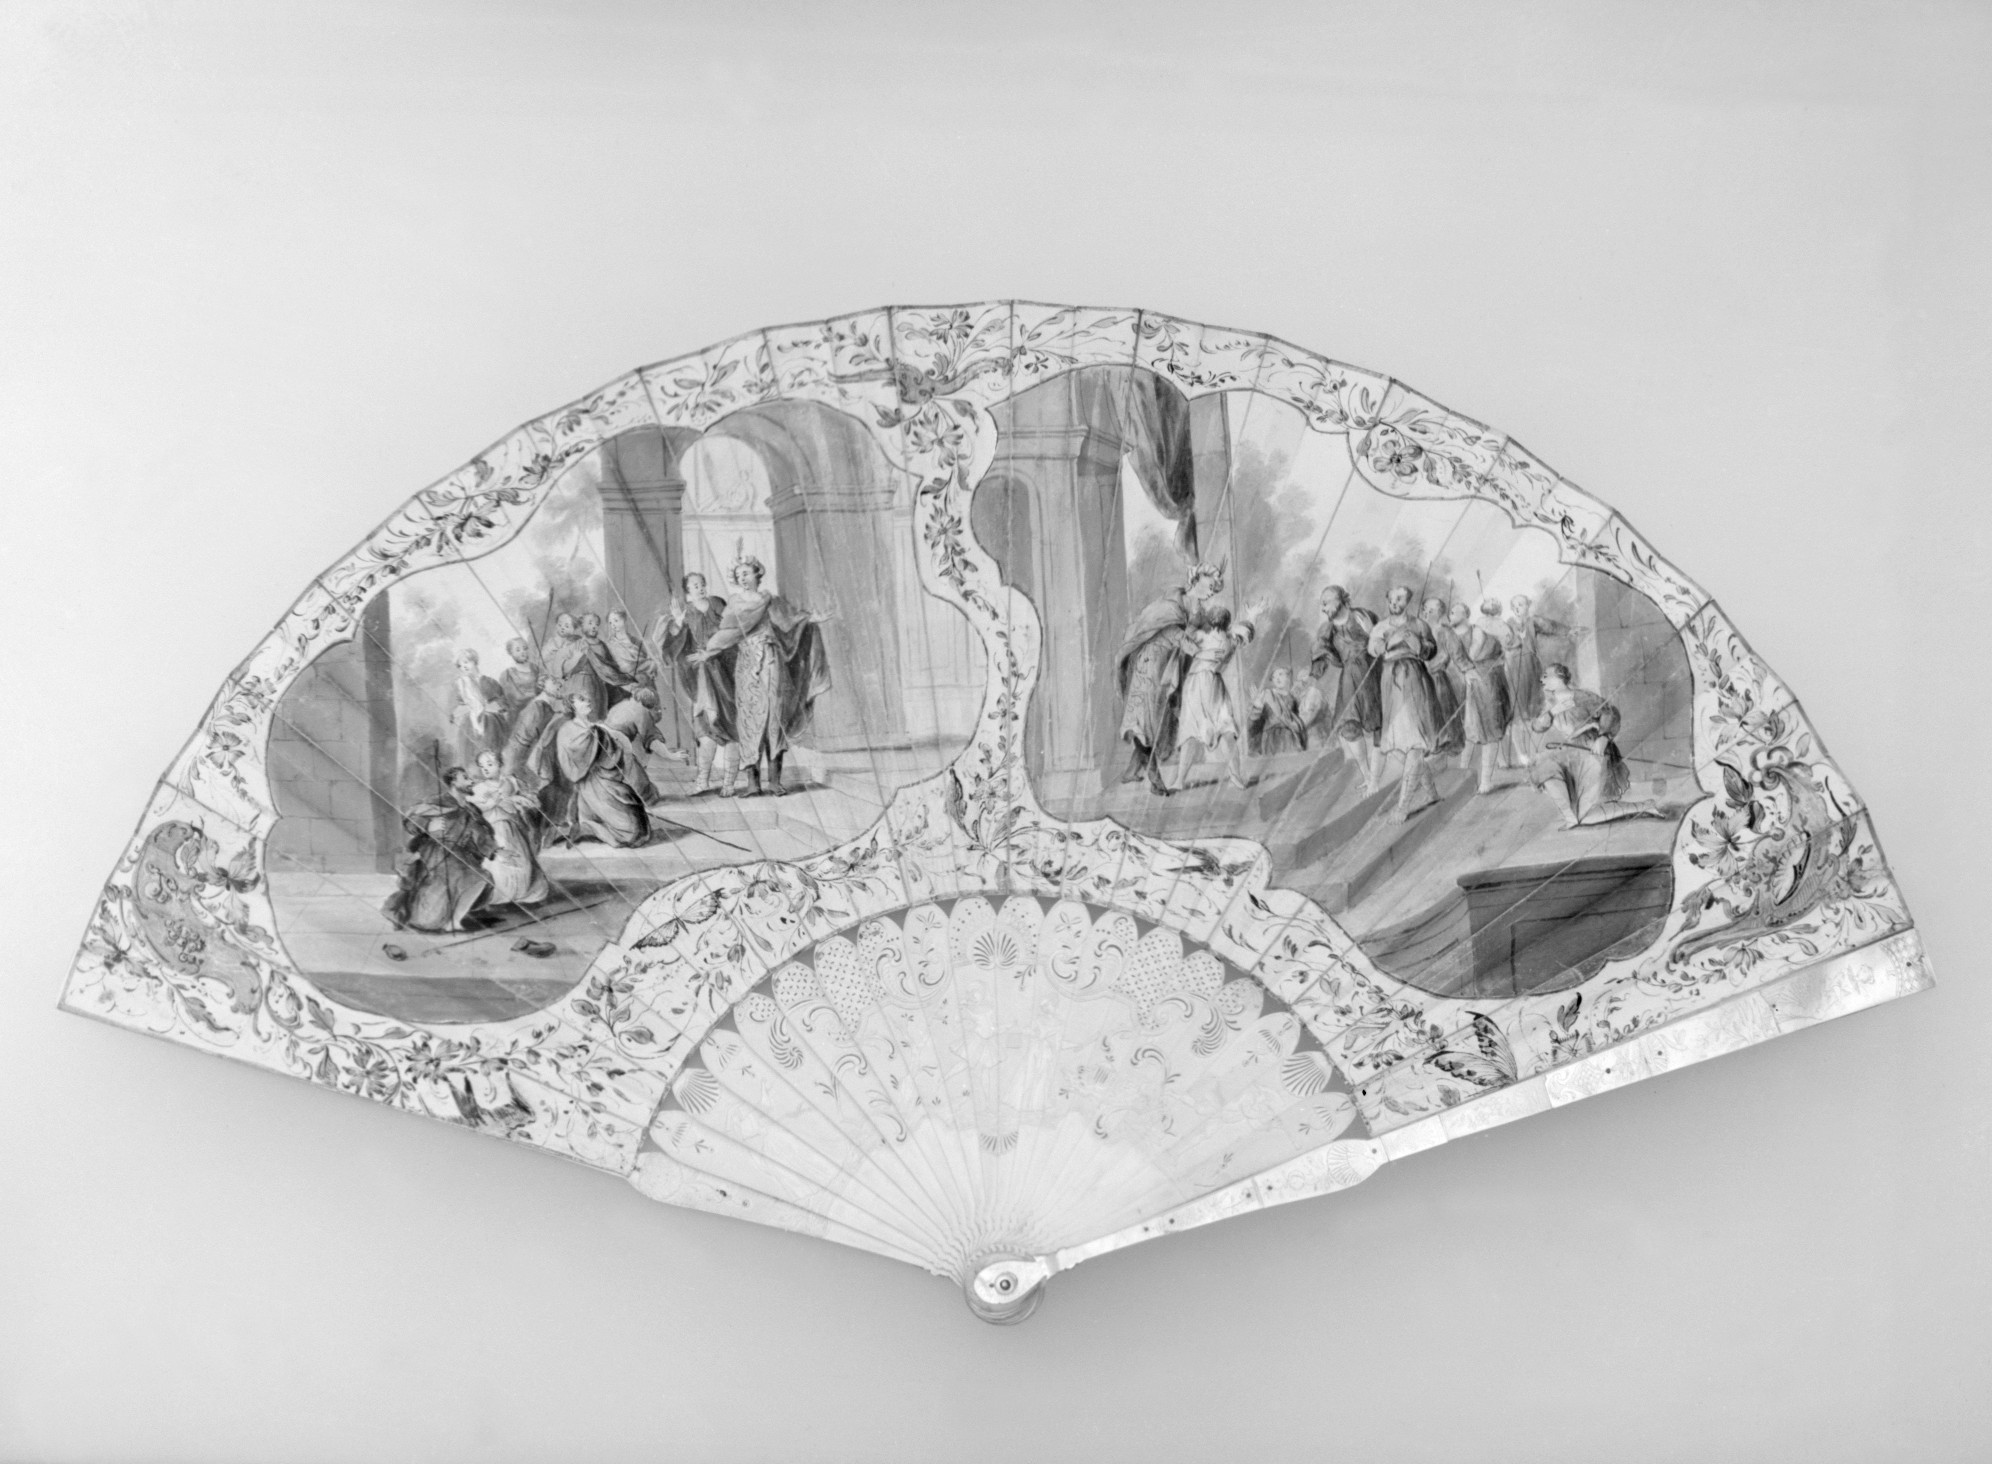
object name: fan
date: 1751-1775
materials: ivory, mother of pearl, paper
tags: men,women